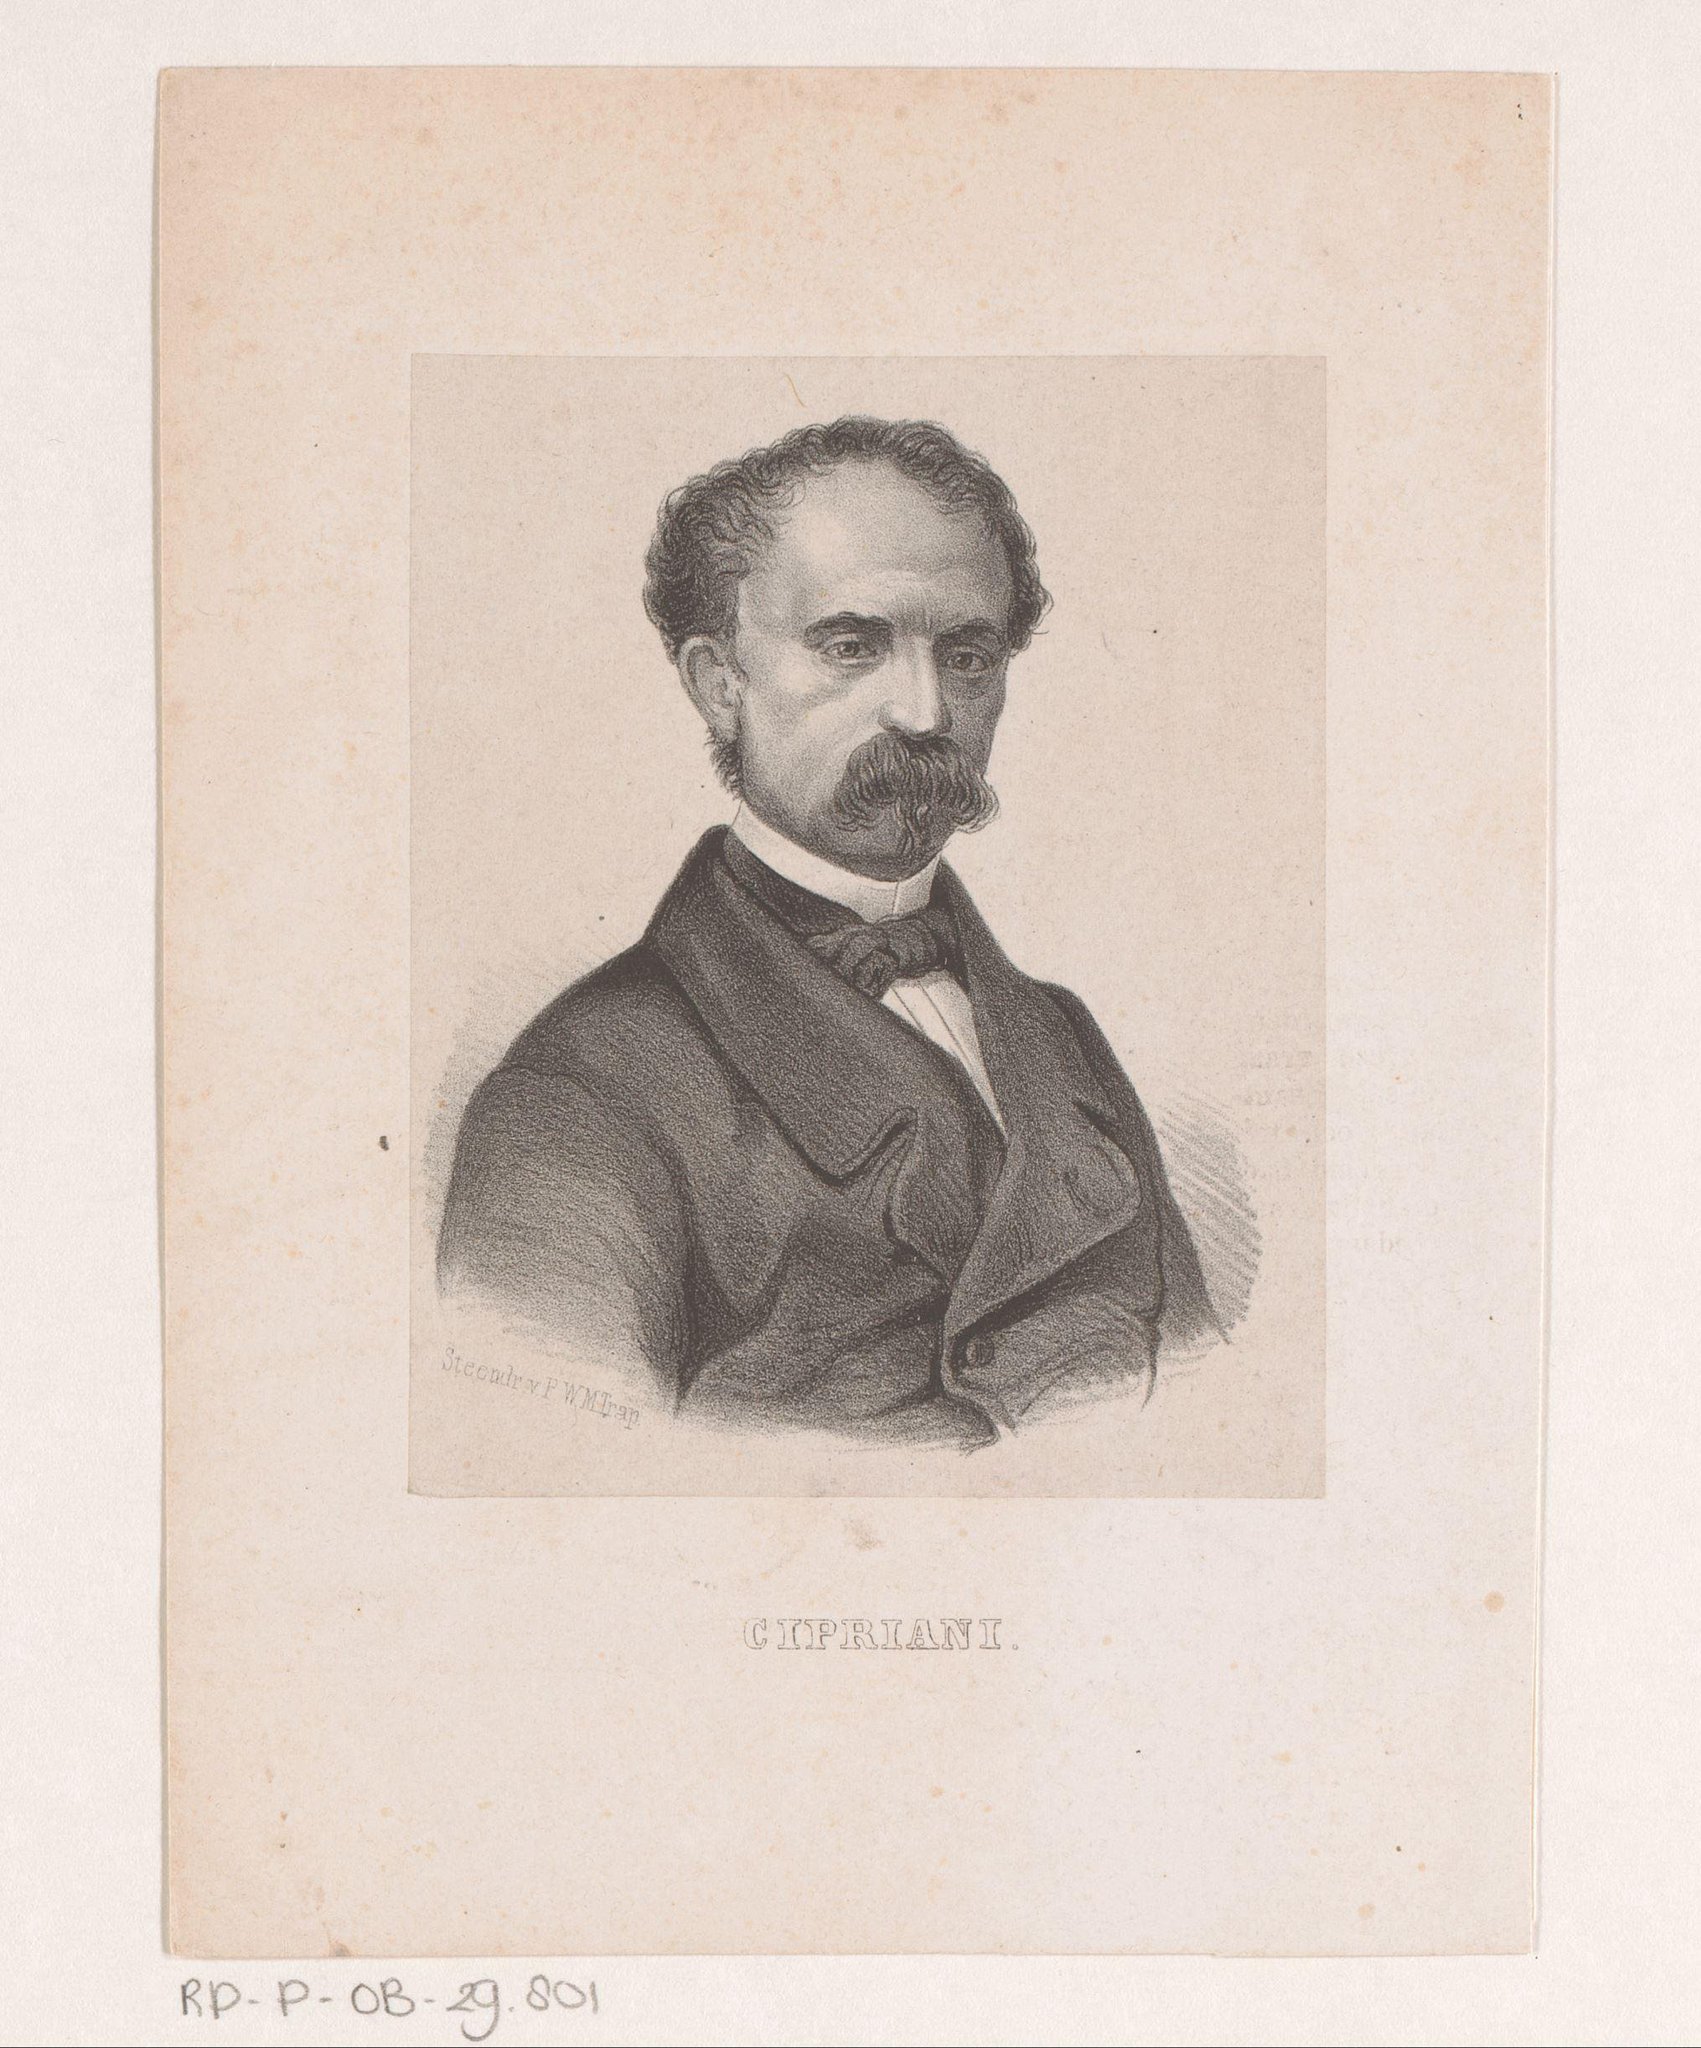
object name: print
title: Cipriani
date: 1836-1905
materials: paper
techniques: lithograph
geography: leiden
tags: historical persons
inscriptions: collector's mark: Lugt 2228